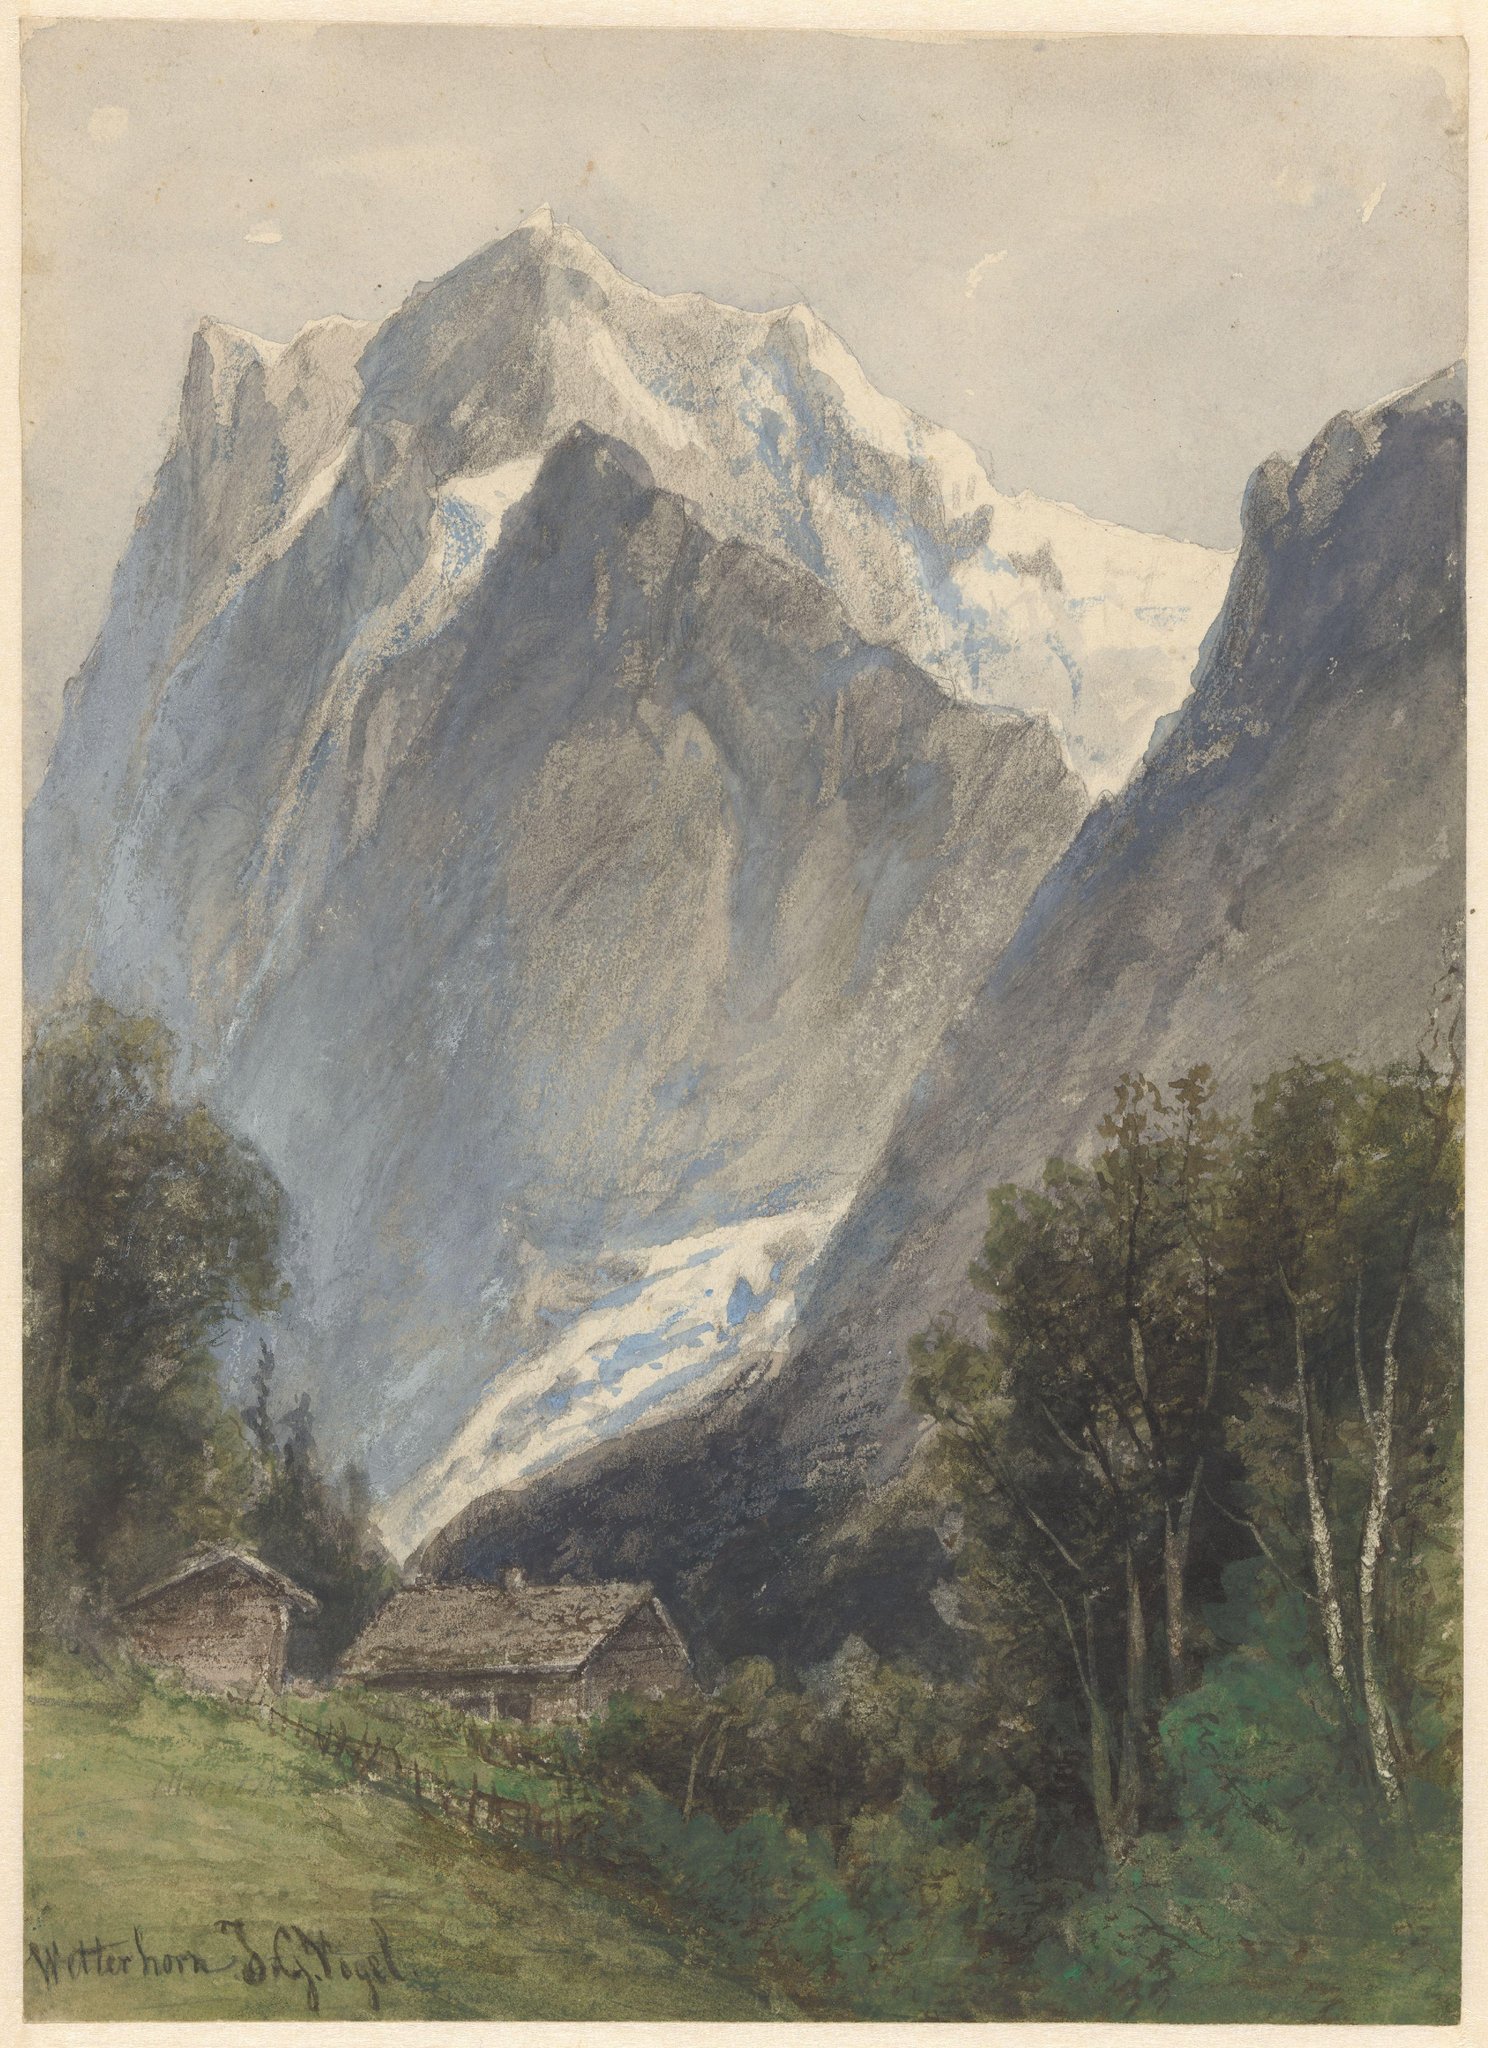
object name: drawing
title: Wetterhorn te Zwitserland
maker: johannes gijsbert vogel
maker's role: draughtsman, painter, print maker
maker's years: 1828-1915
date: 1838-1915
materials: paint, paper, pencil, watercolor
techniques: brush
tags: mountains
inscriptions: annotation: ‘Wetterhorn’, collector's mark: Lugt 1181b